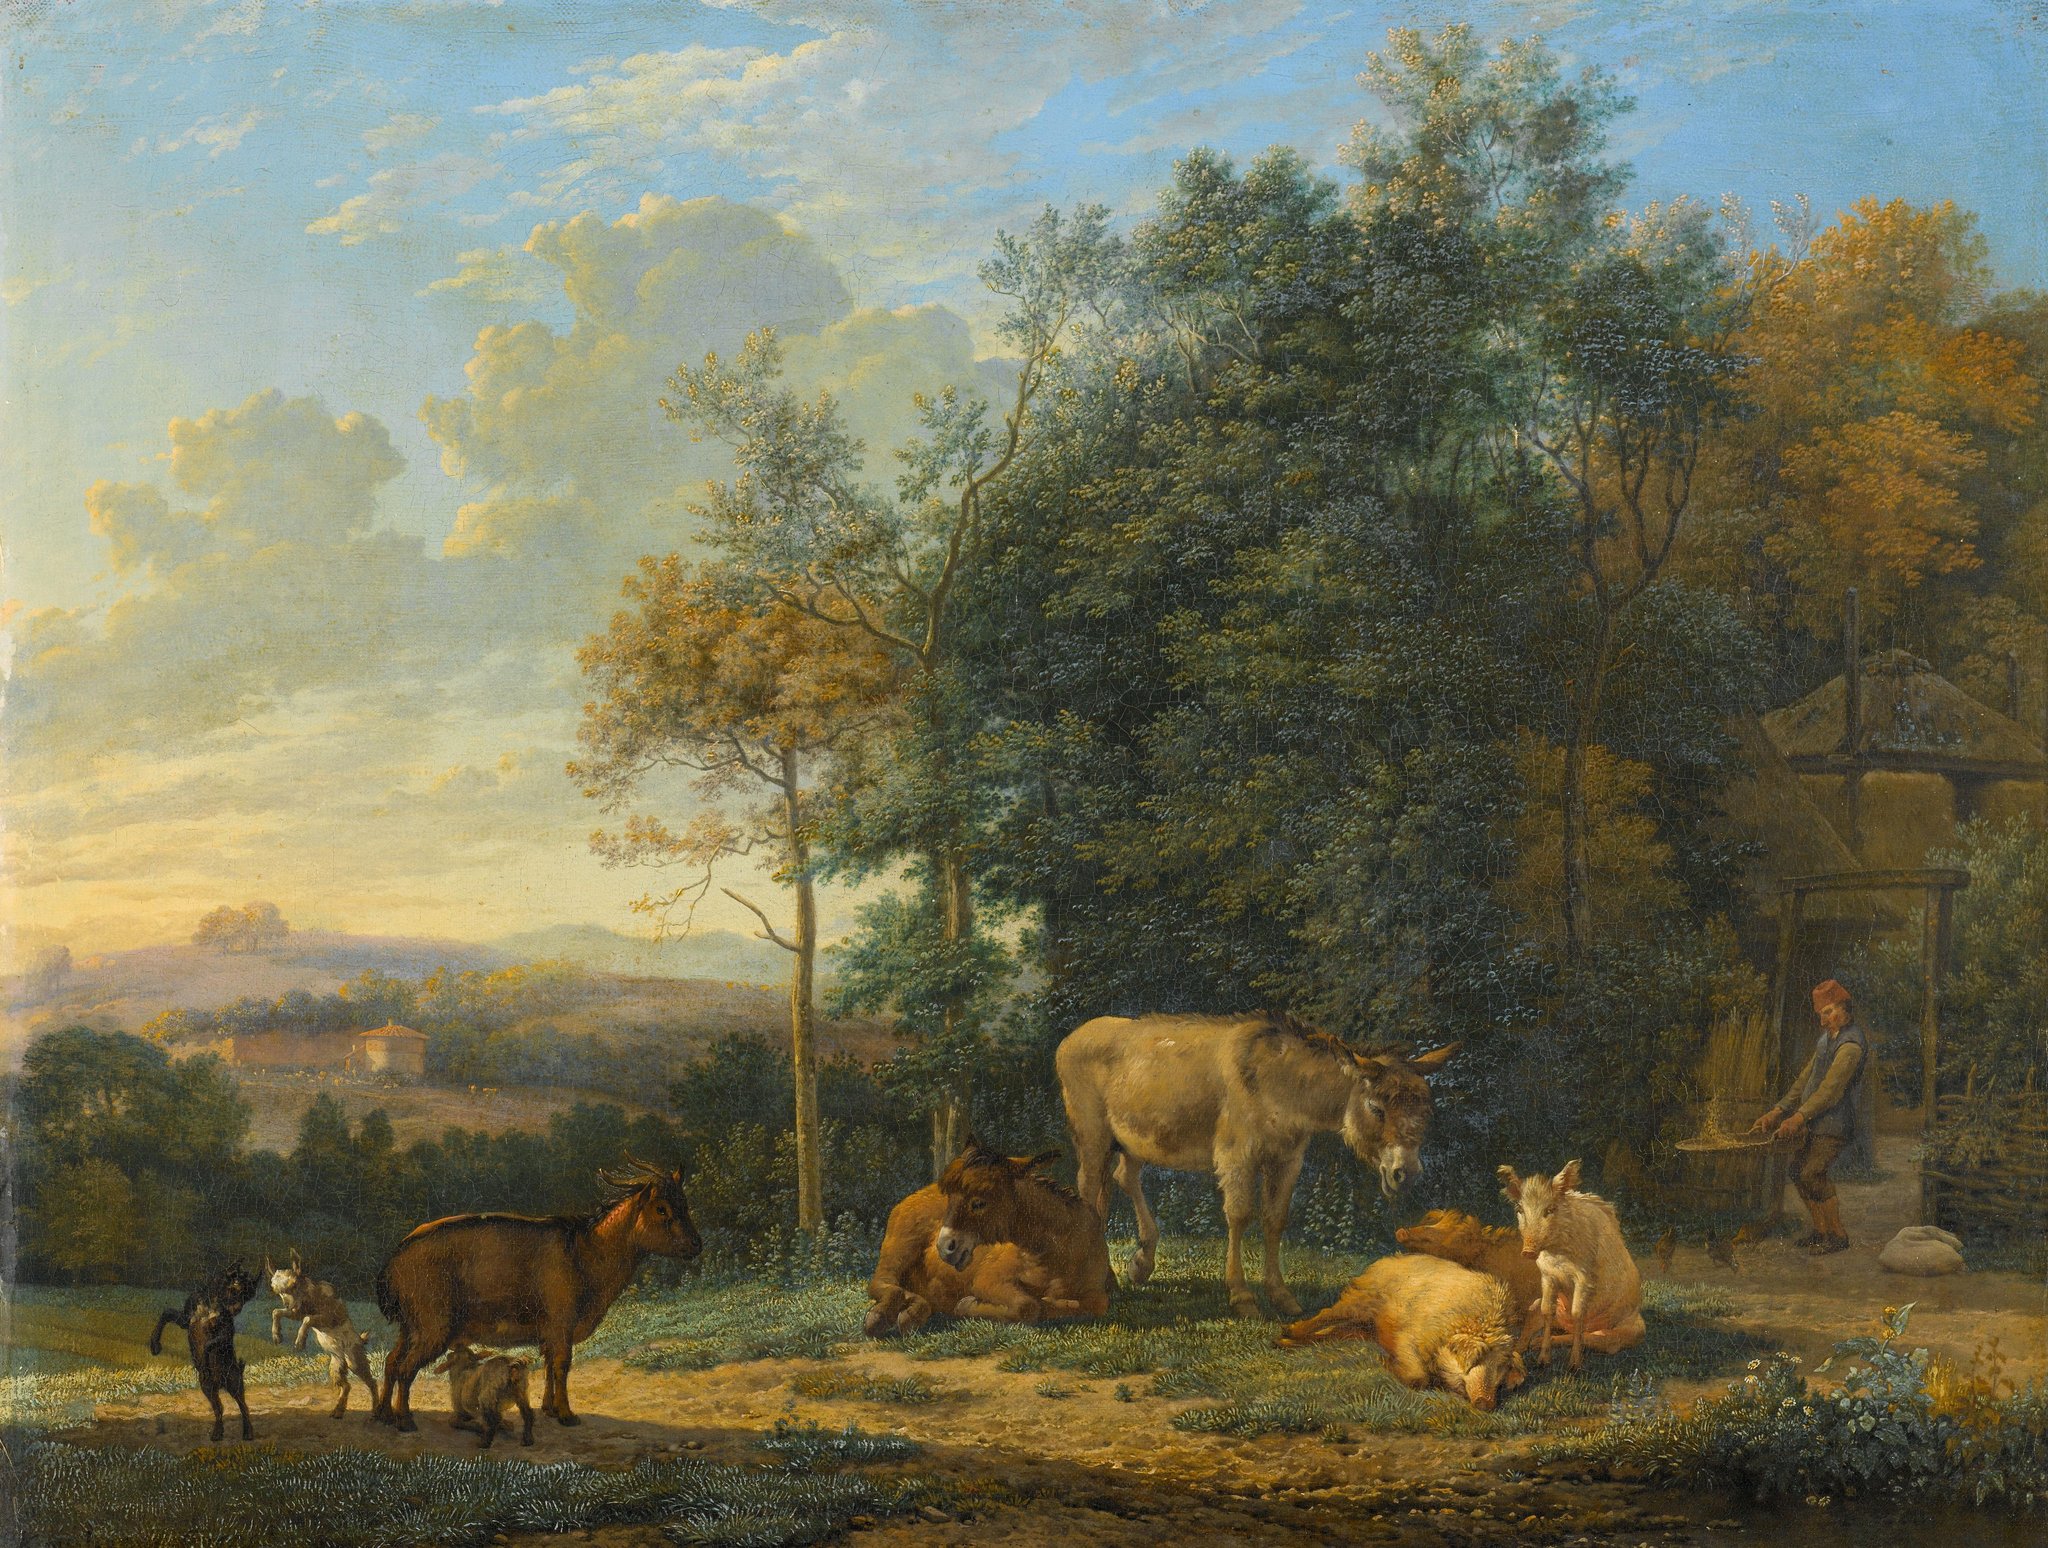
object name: painting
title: Landscape with Two Donkeys, Goats and Pigs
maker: karel du jardin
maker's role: draughtsman, painter, print maker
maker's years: 1626-1678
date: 1655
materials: canvas, oil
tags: pig, ass, donkey, landscapes in the temperate zone, goat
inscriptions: signature and date: ‘K: du Iardin. fe 1655.’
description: A farmer separates the wheat from the chaff, while chickens eagerly pick at the fallen grains. The raking light of the low-hanging sun evokes an early evening atmosphere. The architectural style of the cylindrical building in the distance situates the scene in Italy. Such southern pastoral and peasant idylls were Du Jardin’s speciality.